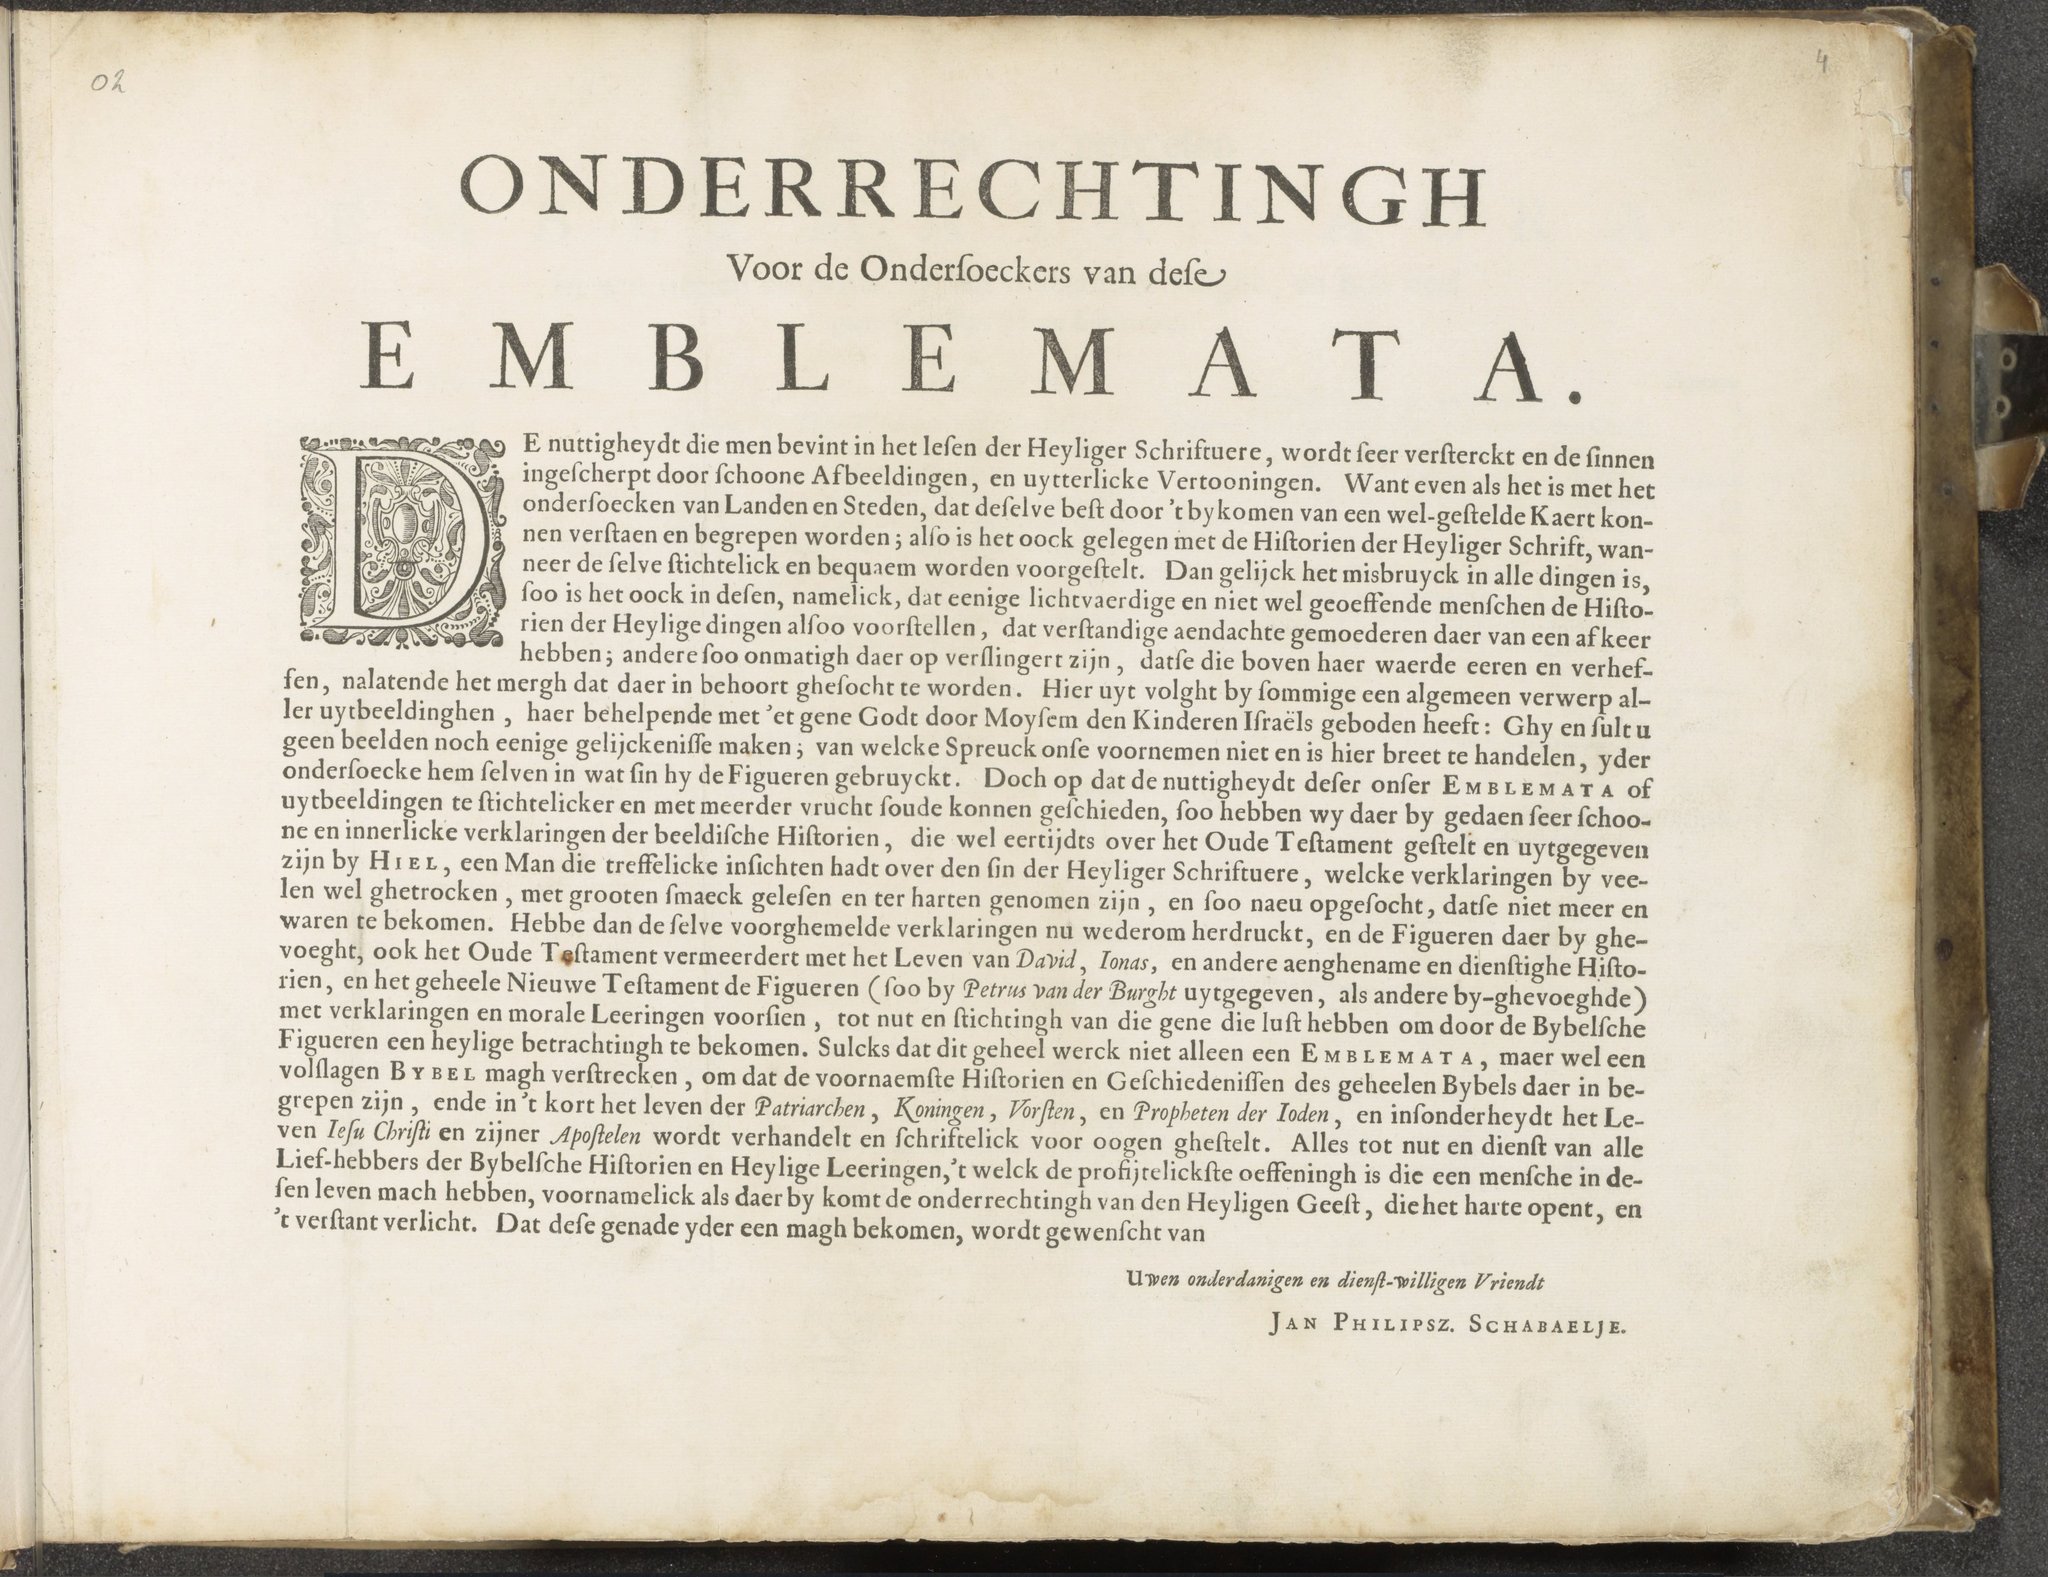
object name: text sheet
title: Voorwoord bij de Grooten Emblemata Sacra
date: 1653-1654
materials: paper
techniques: letterpress printing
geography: amsterdam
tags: initial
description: Voorwoord bij de Grooten Emblemata Sacra, ondertekend door Jan Philipsz Schabaelje. De tekst vangt aan met een gedecoreerde initiaal D. Het blad maakt deel uit van een album.